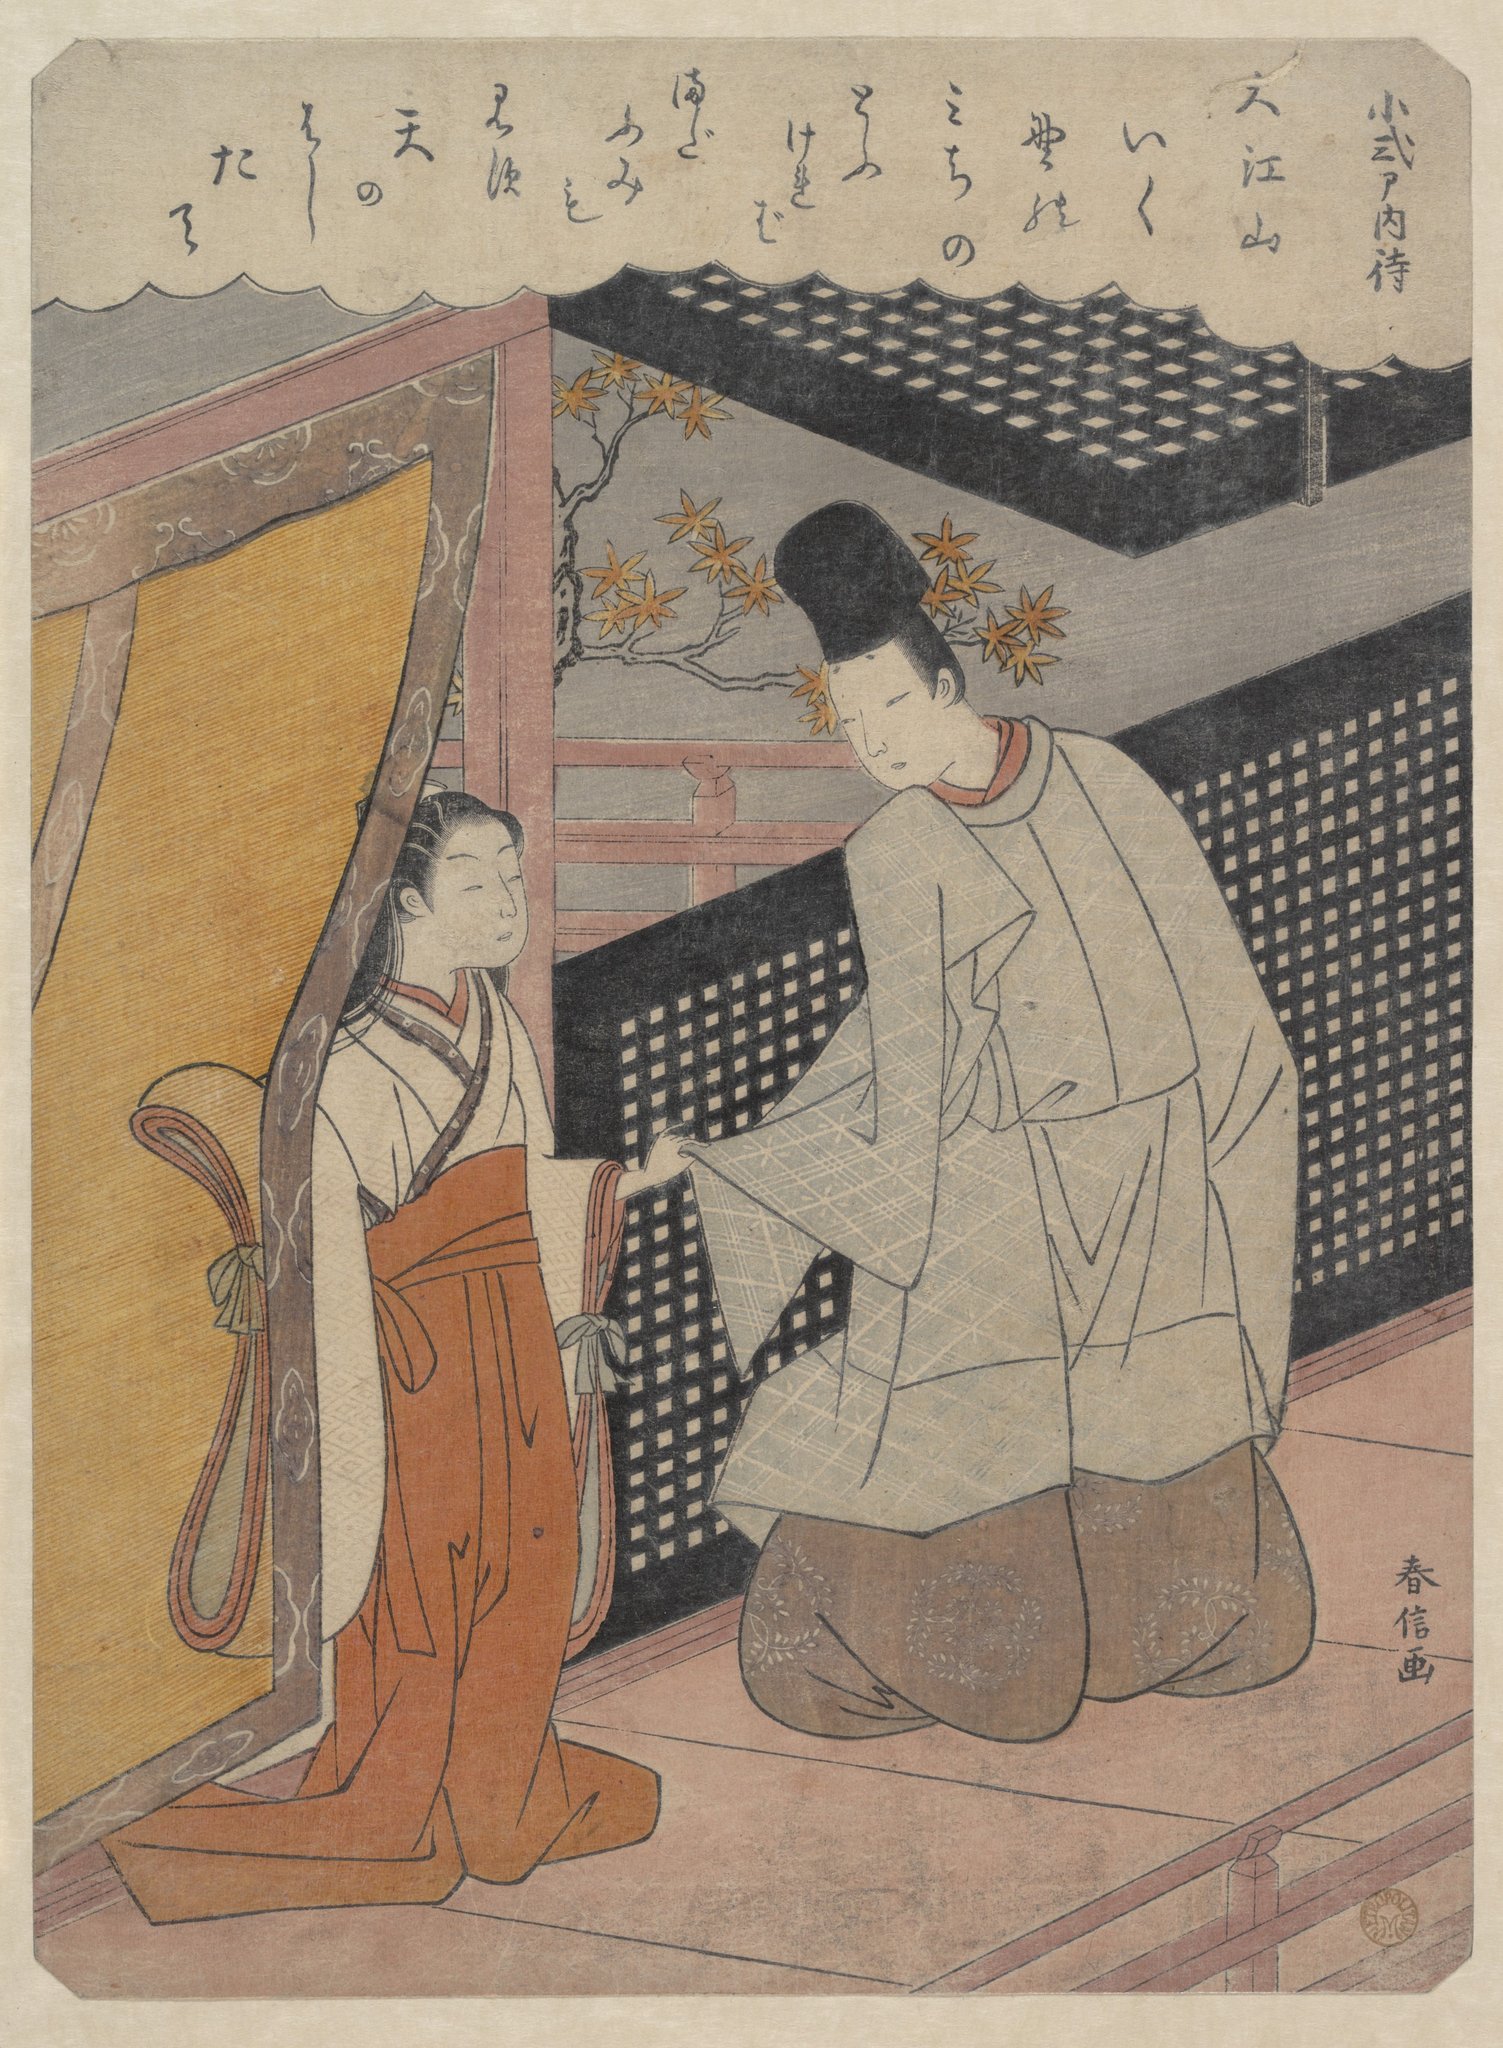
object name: print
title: Koshikibu no Naishi (999–1025), from "Hyakunin Isshu" (One Hundred Poems by One Hundred Poets)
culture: japanese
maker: suzuki harunobu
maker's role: artist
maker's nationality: japanese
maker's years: 1725-1770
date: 1768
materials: ink, paper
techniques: woodblock print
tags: men,women